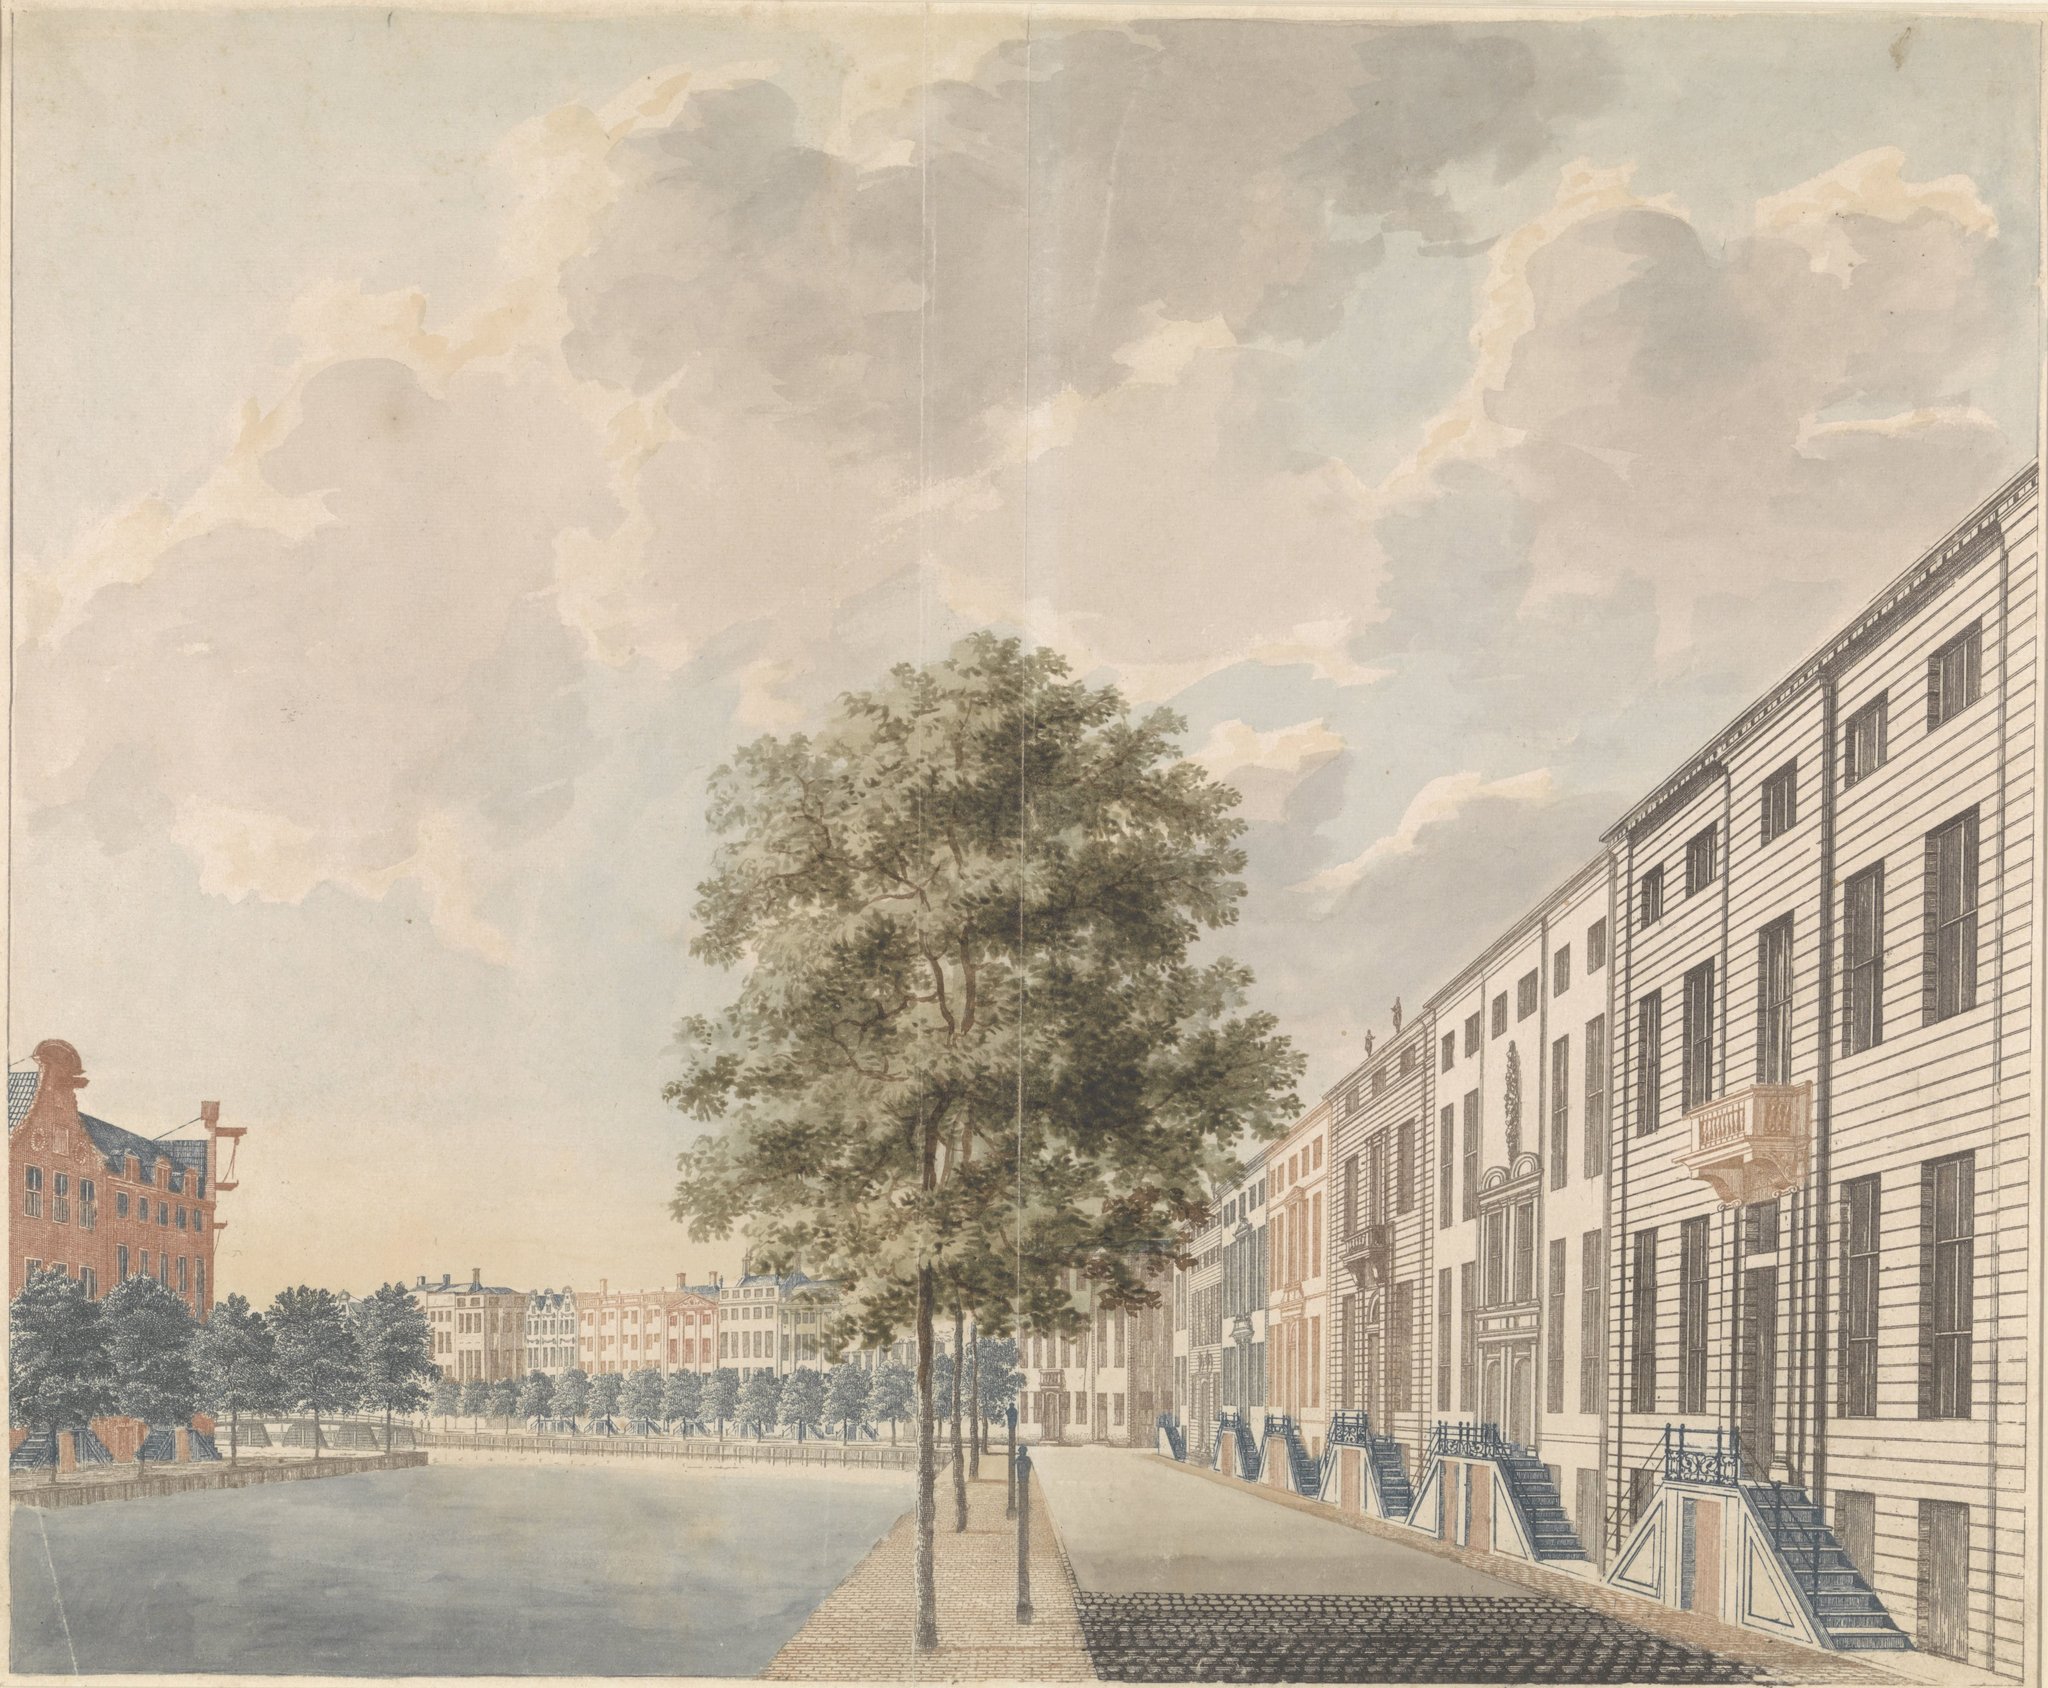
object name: print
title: Gezicht op de Herengracht bij de Spiegelstraat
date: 1688-1698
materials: paper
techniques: etching, hand coloring, lithography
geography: netherlands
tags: canal, the usual house or row of houses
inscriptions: collector's mark: Lugt 2760, collector's mark: Lugt 2228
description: Gezicht op de Herengracht met rechts in de bocht de hoek met de Spiegelstraat.